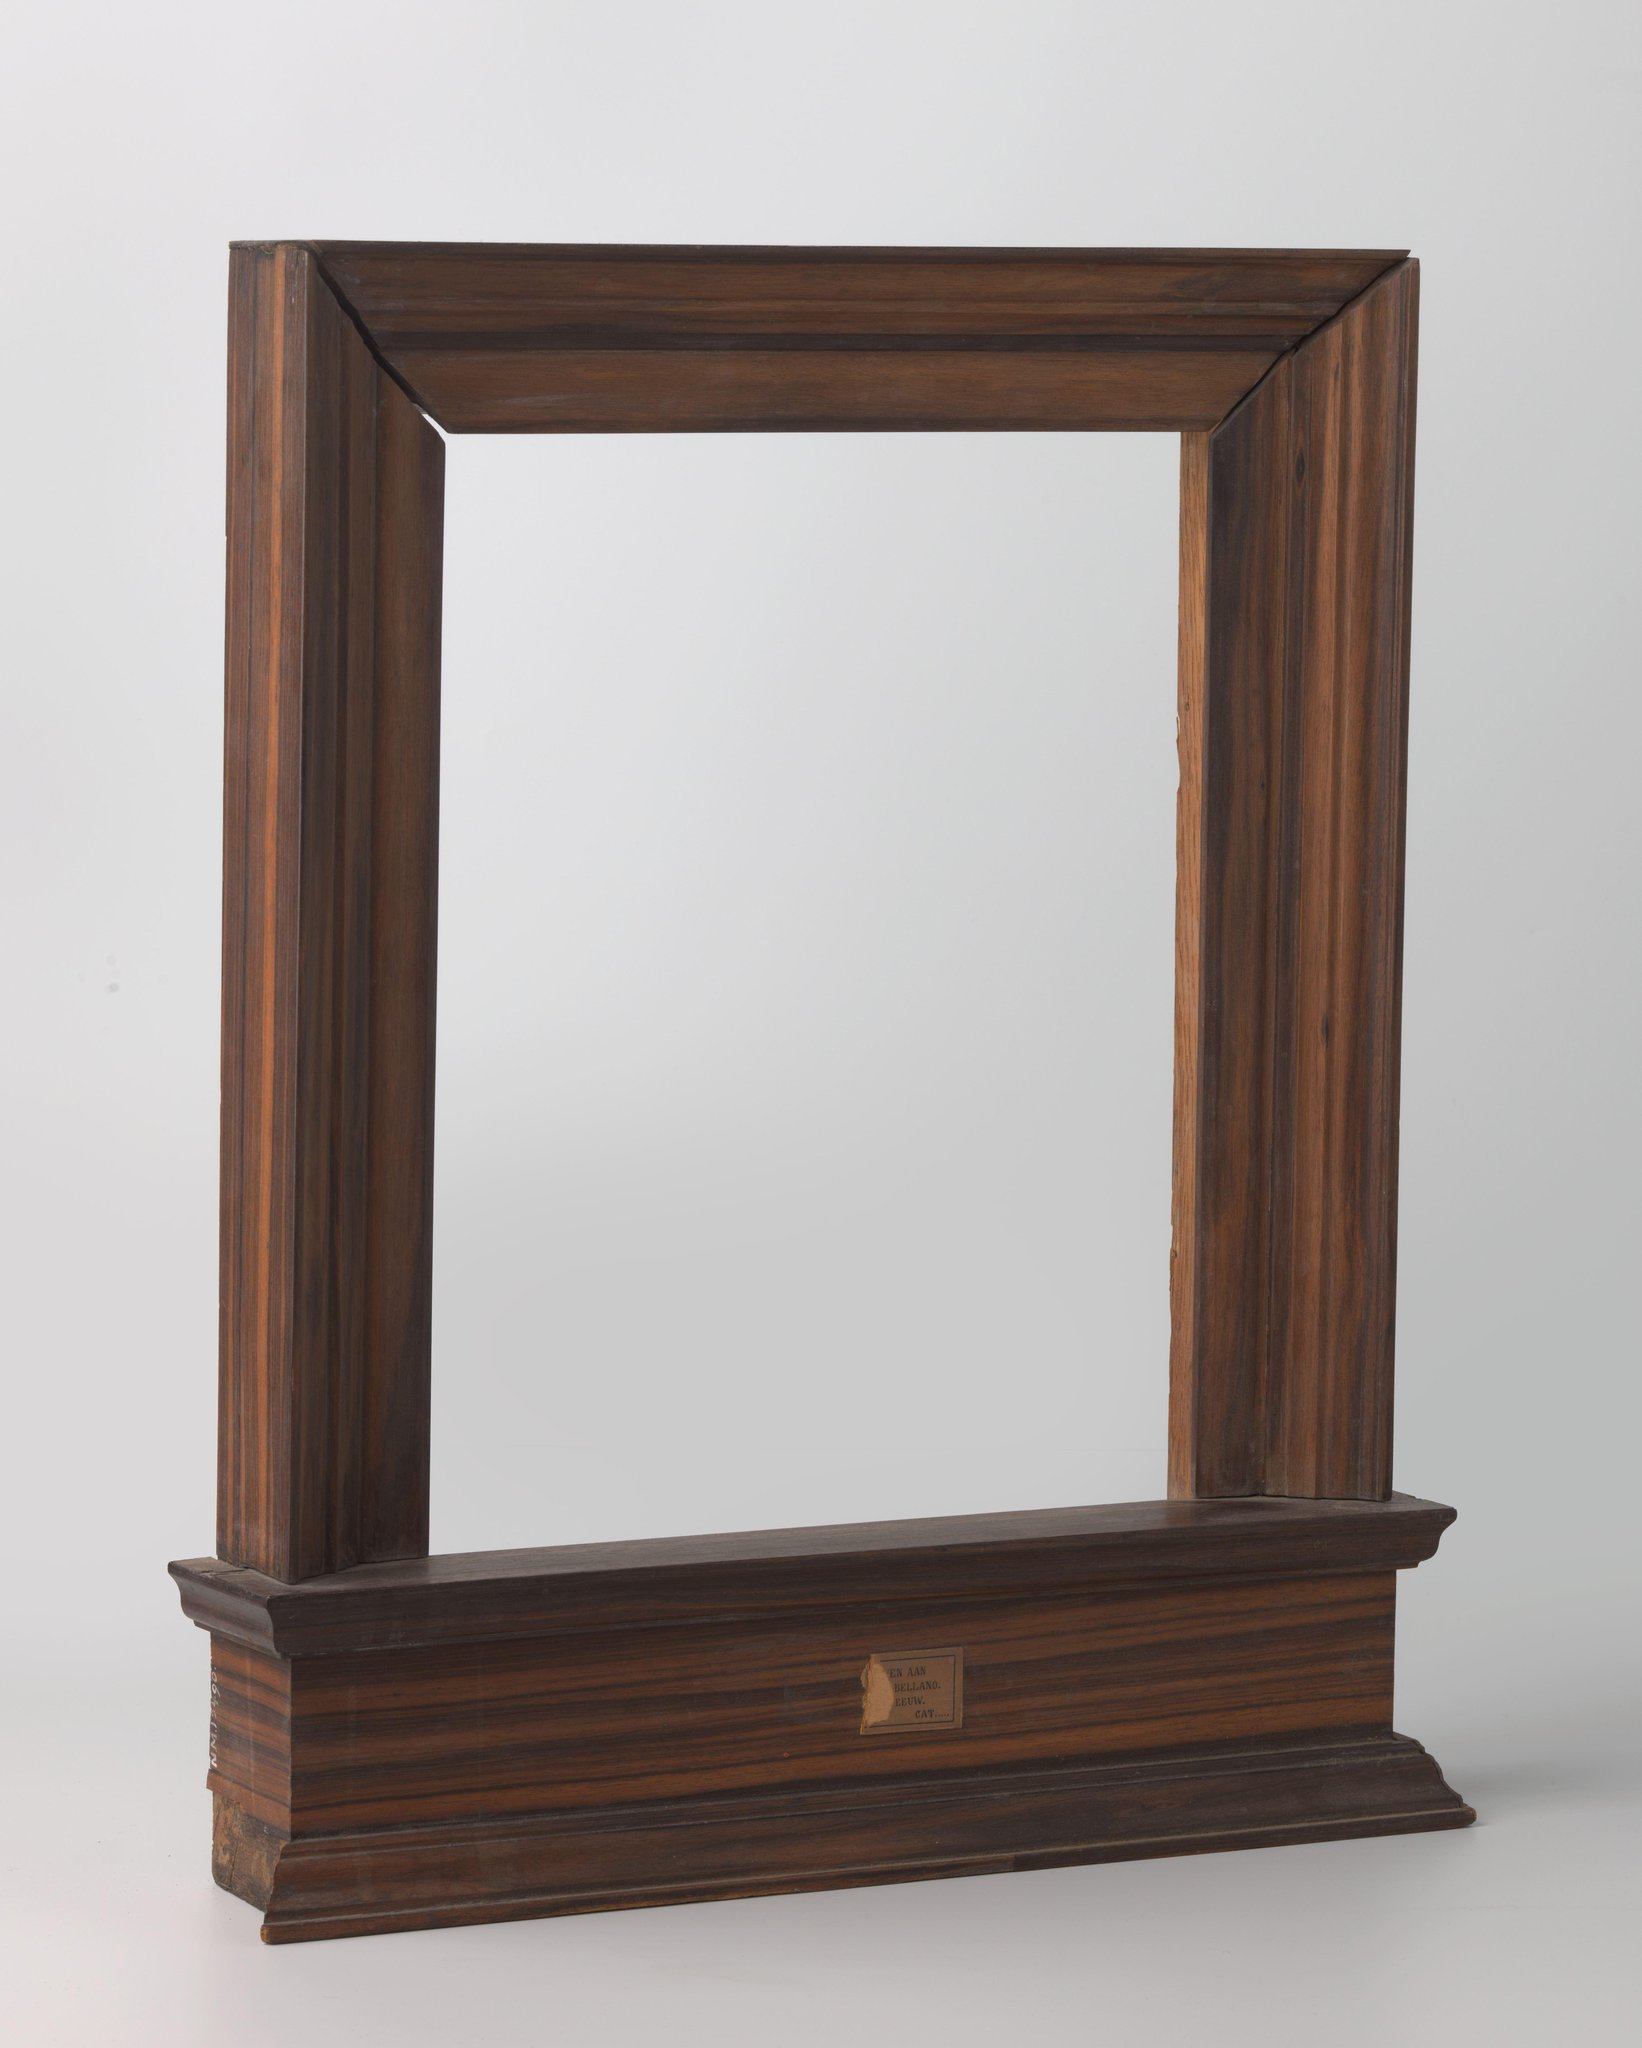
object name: frame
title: Gefineerde houten lijst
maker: Anonymous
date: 1875-1924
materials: wood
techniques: veneering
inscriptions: plate: ‘... van aan // ... bellano. // ... eeuw // ... cat.’, annotation: ‘NM 12490’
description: Lijst is geïnspireerd op de architraaflijsten. Lijst van hout, vroegere omlijsting van het relief Maria met kind (BK-12490). Op de achterzijde zijn twee ophangogen en twee hoekijzers gemonteerd.